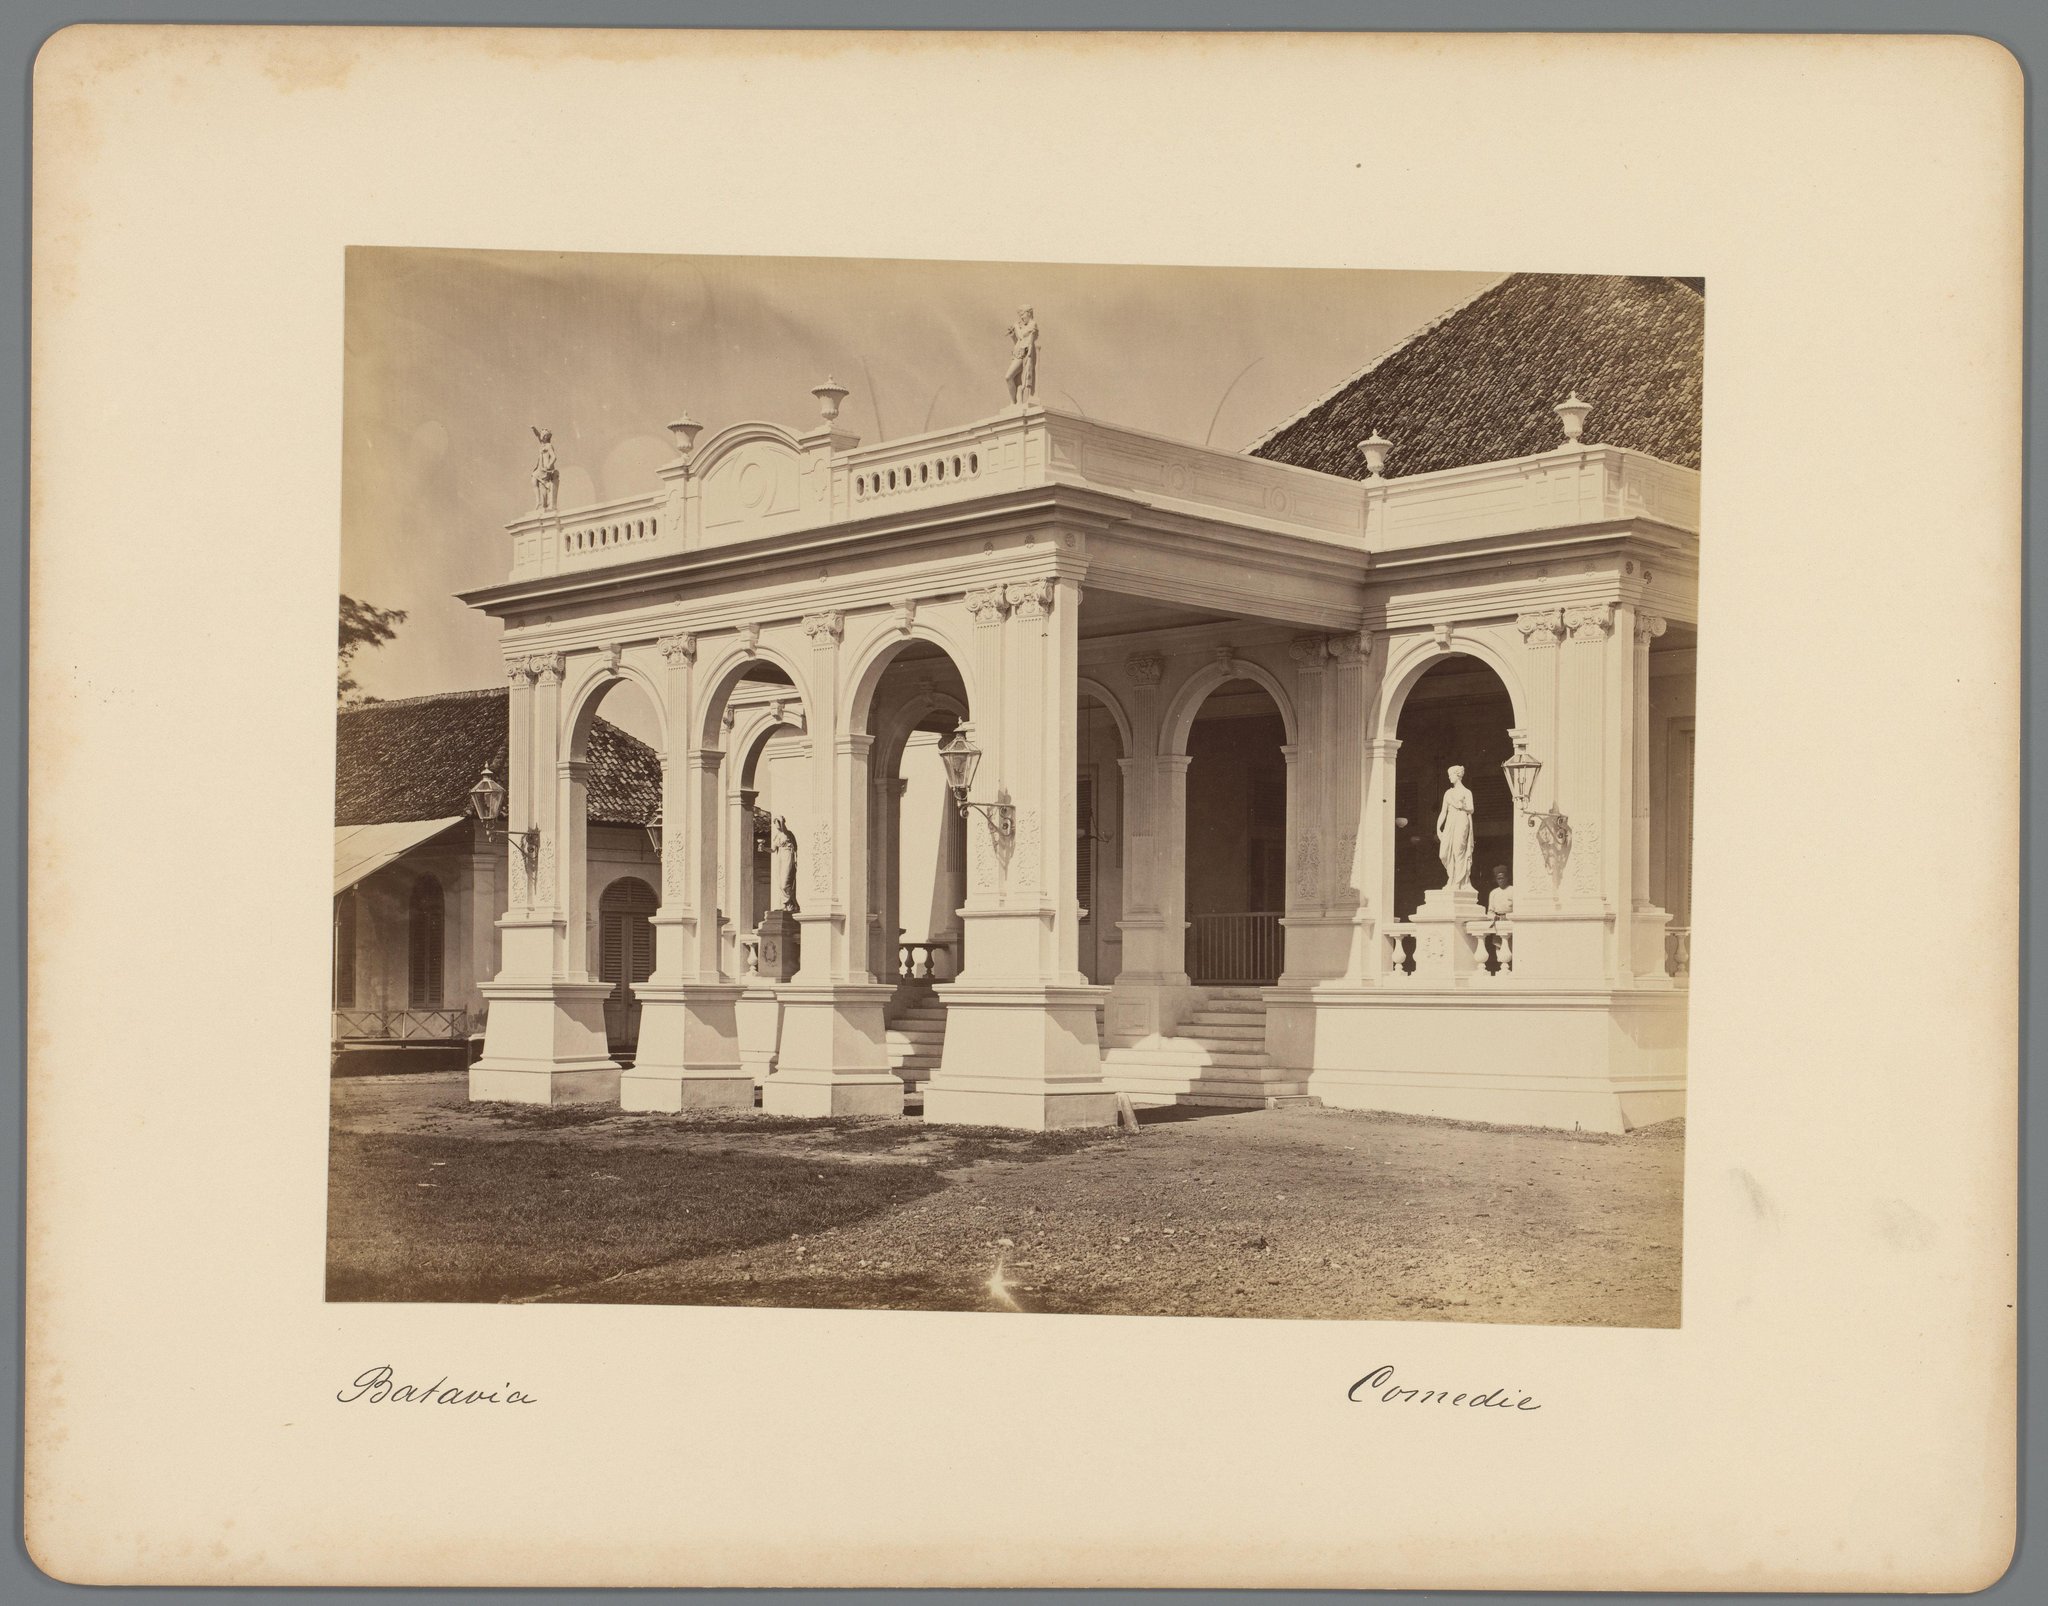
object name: photograph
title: Deel van het exterieur van Schouwburg Weltevreden in Batavia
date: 1857-1908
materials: cardboard, paper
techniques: albumen print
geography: batavia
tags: theatre (building), exterior ~ representation of a building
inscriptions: inscription: ‘FOTO’, inscription: ‘PHOTOGRAFIEEN VAN NED: INDIE BATAVIA’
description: Deze foto zat oorspronkelijk in prentenkabinet RP-F-AA3192.